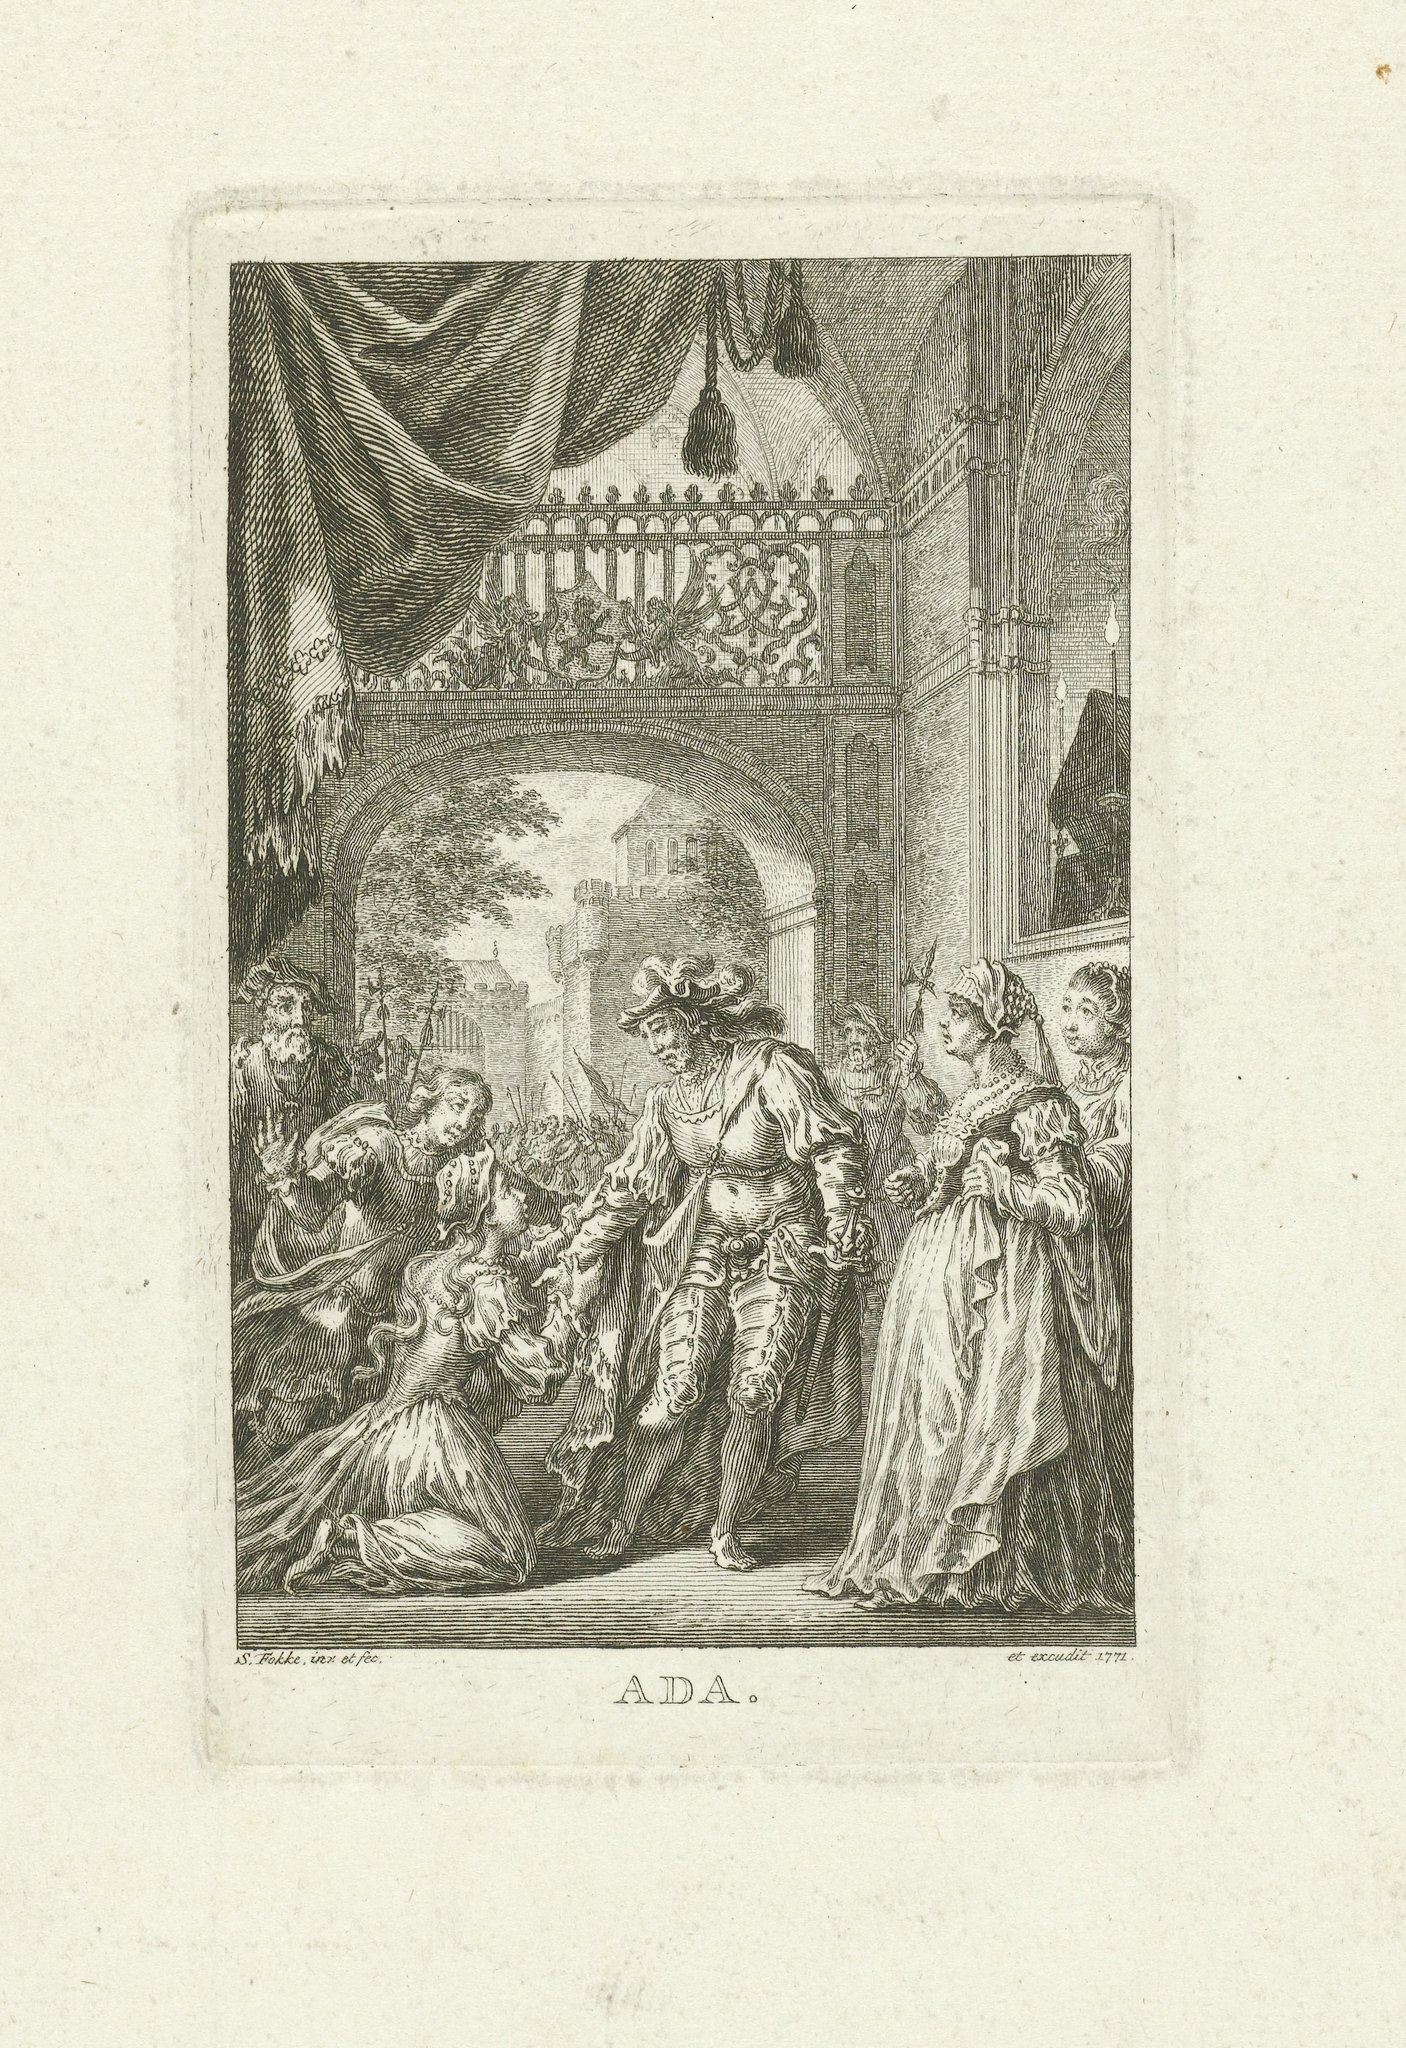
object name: print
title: Ada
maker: simon fokke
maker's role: draughtsman, print maker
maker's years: 1712-1784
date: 1771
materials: paper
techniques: etching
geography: amsterdam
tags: tragedy, kneeling on both knees - aa - female human figure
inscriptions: collector's mark: Lugt 2228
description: Een edelvrouw knielt voor een graaf en heeft zijn hand vastgepakt. Drie vrouwen en een man staan om hen heen en slaan het tafereel gade. Deze prent is vervaardigd voor het treurspel "Ada, gravin van Holland en Zeeland" (1765) door F. van Steenwijk.